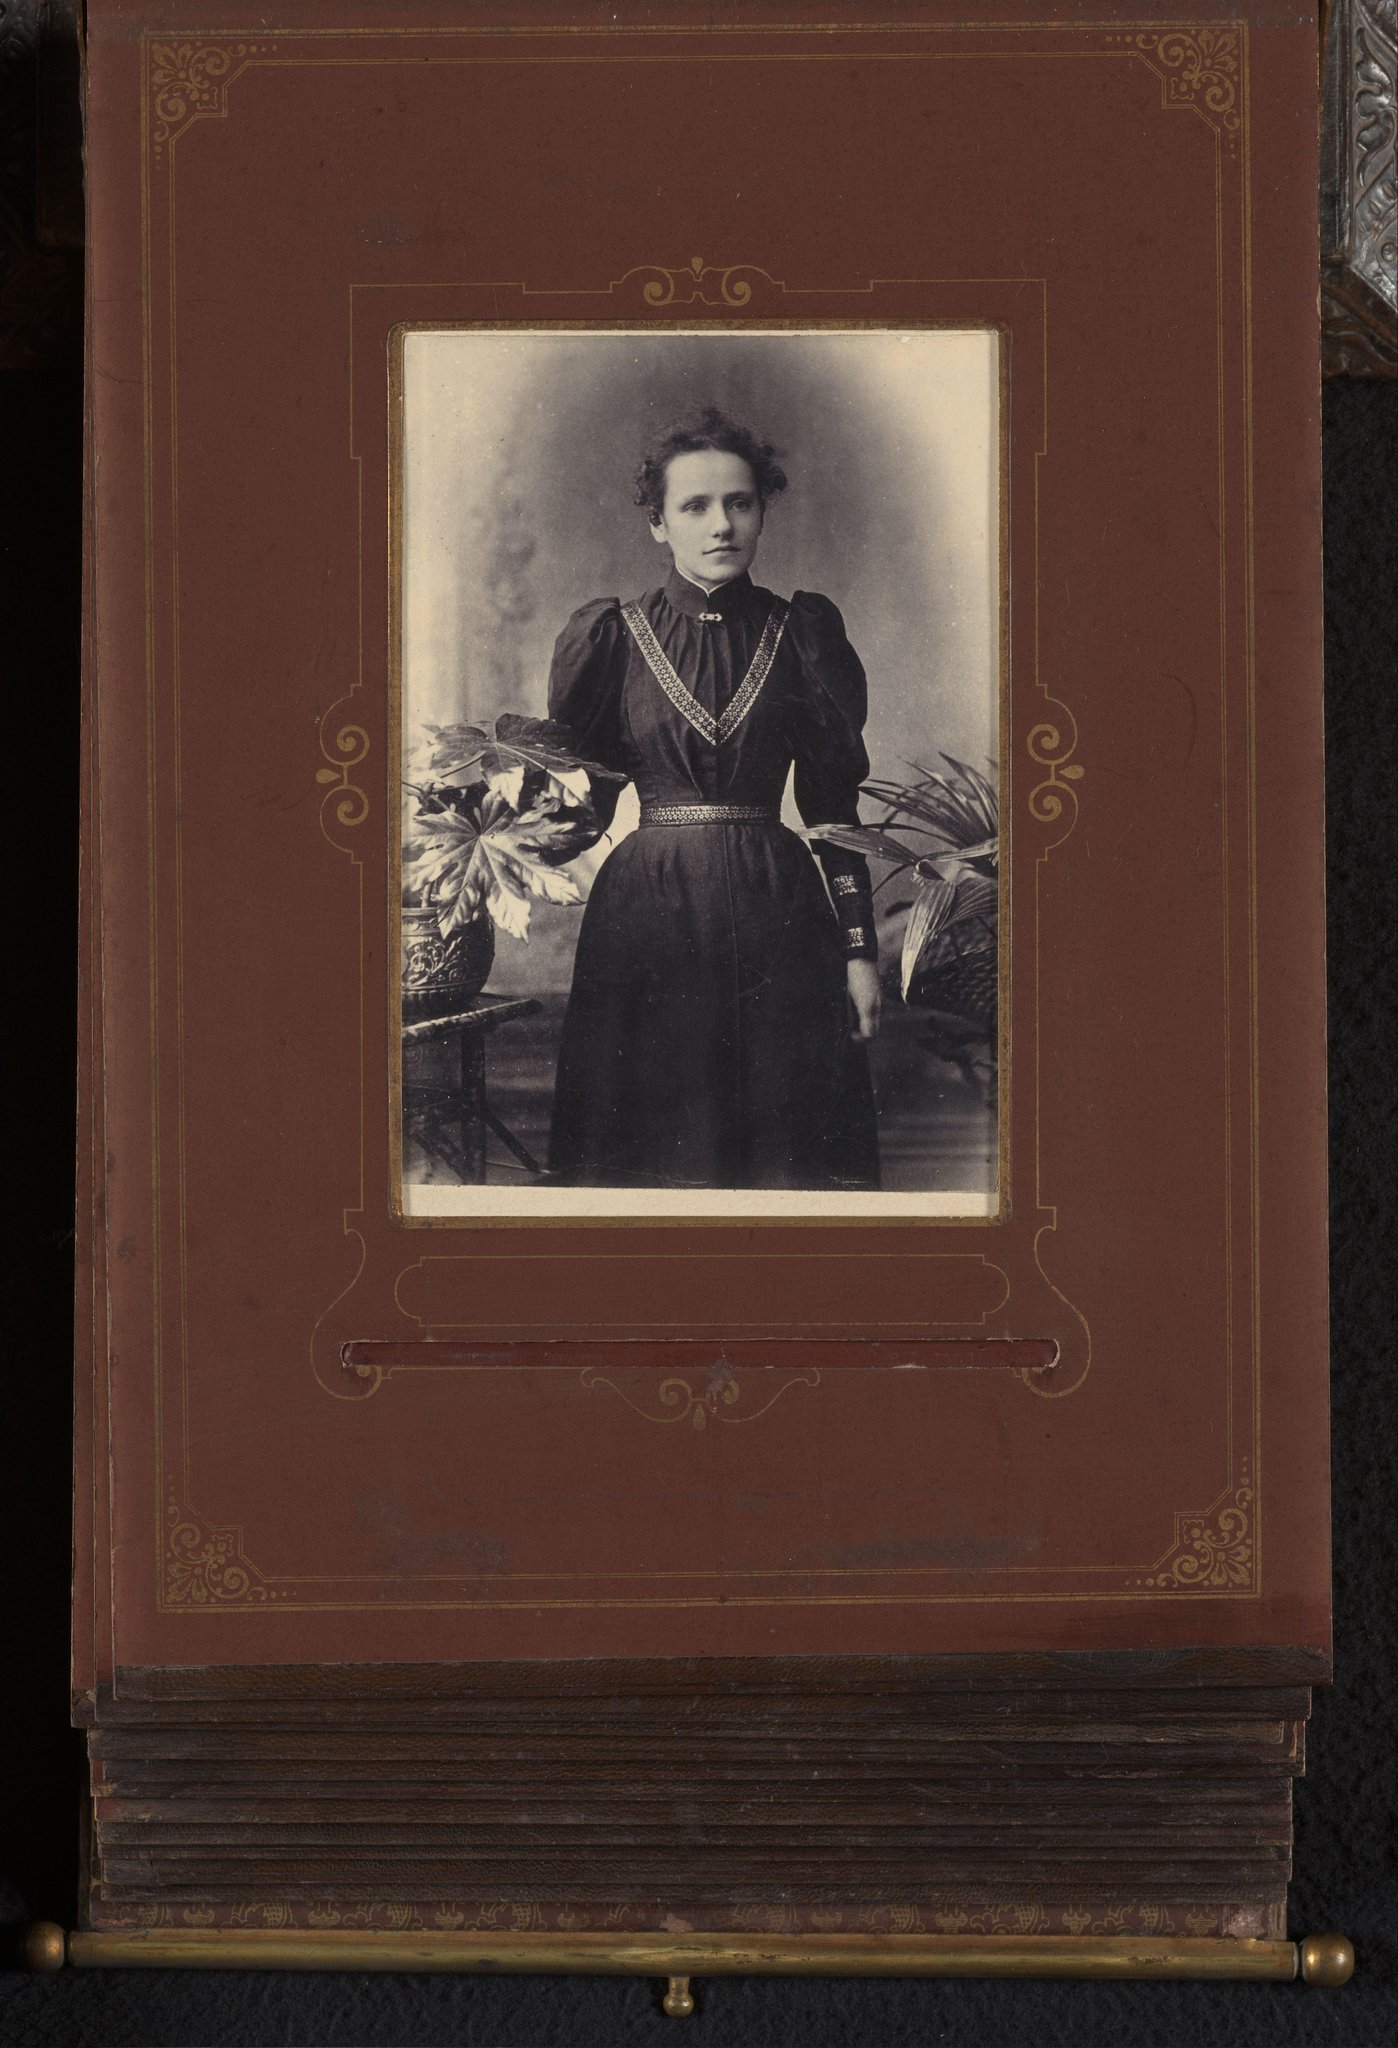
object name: album leaf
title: Portret van een vrouw, staand bij een plant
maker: Anonymous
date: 1880-1920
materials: cardboard, photographic support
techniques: gelatin silver print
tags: historical persons - bb - woman, standing figure - aa - female human figure